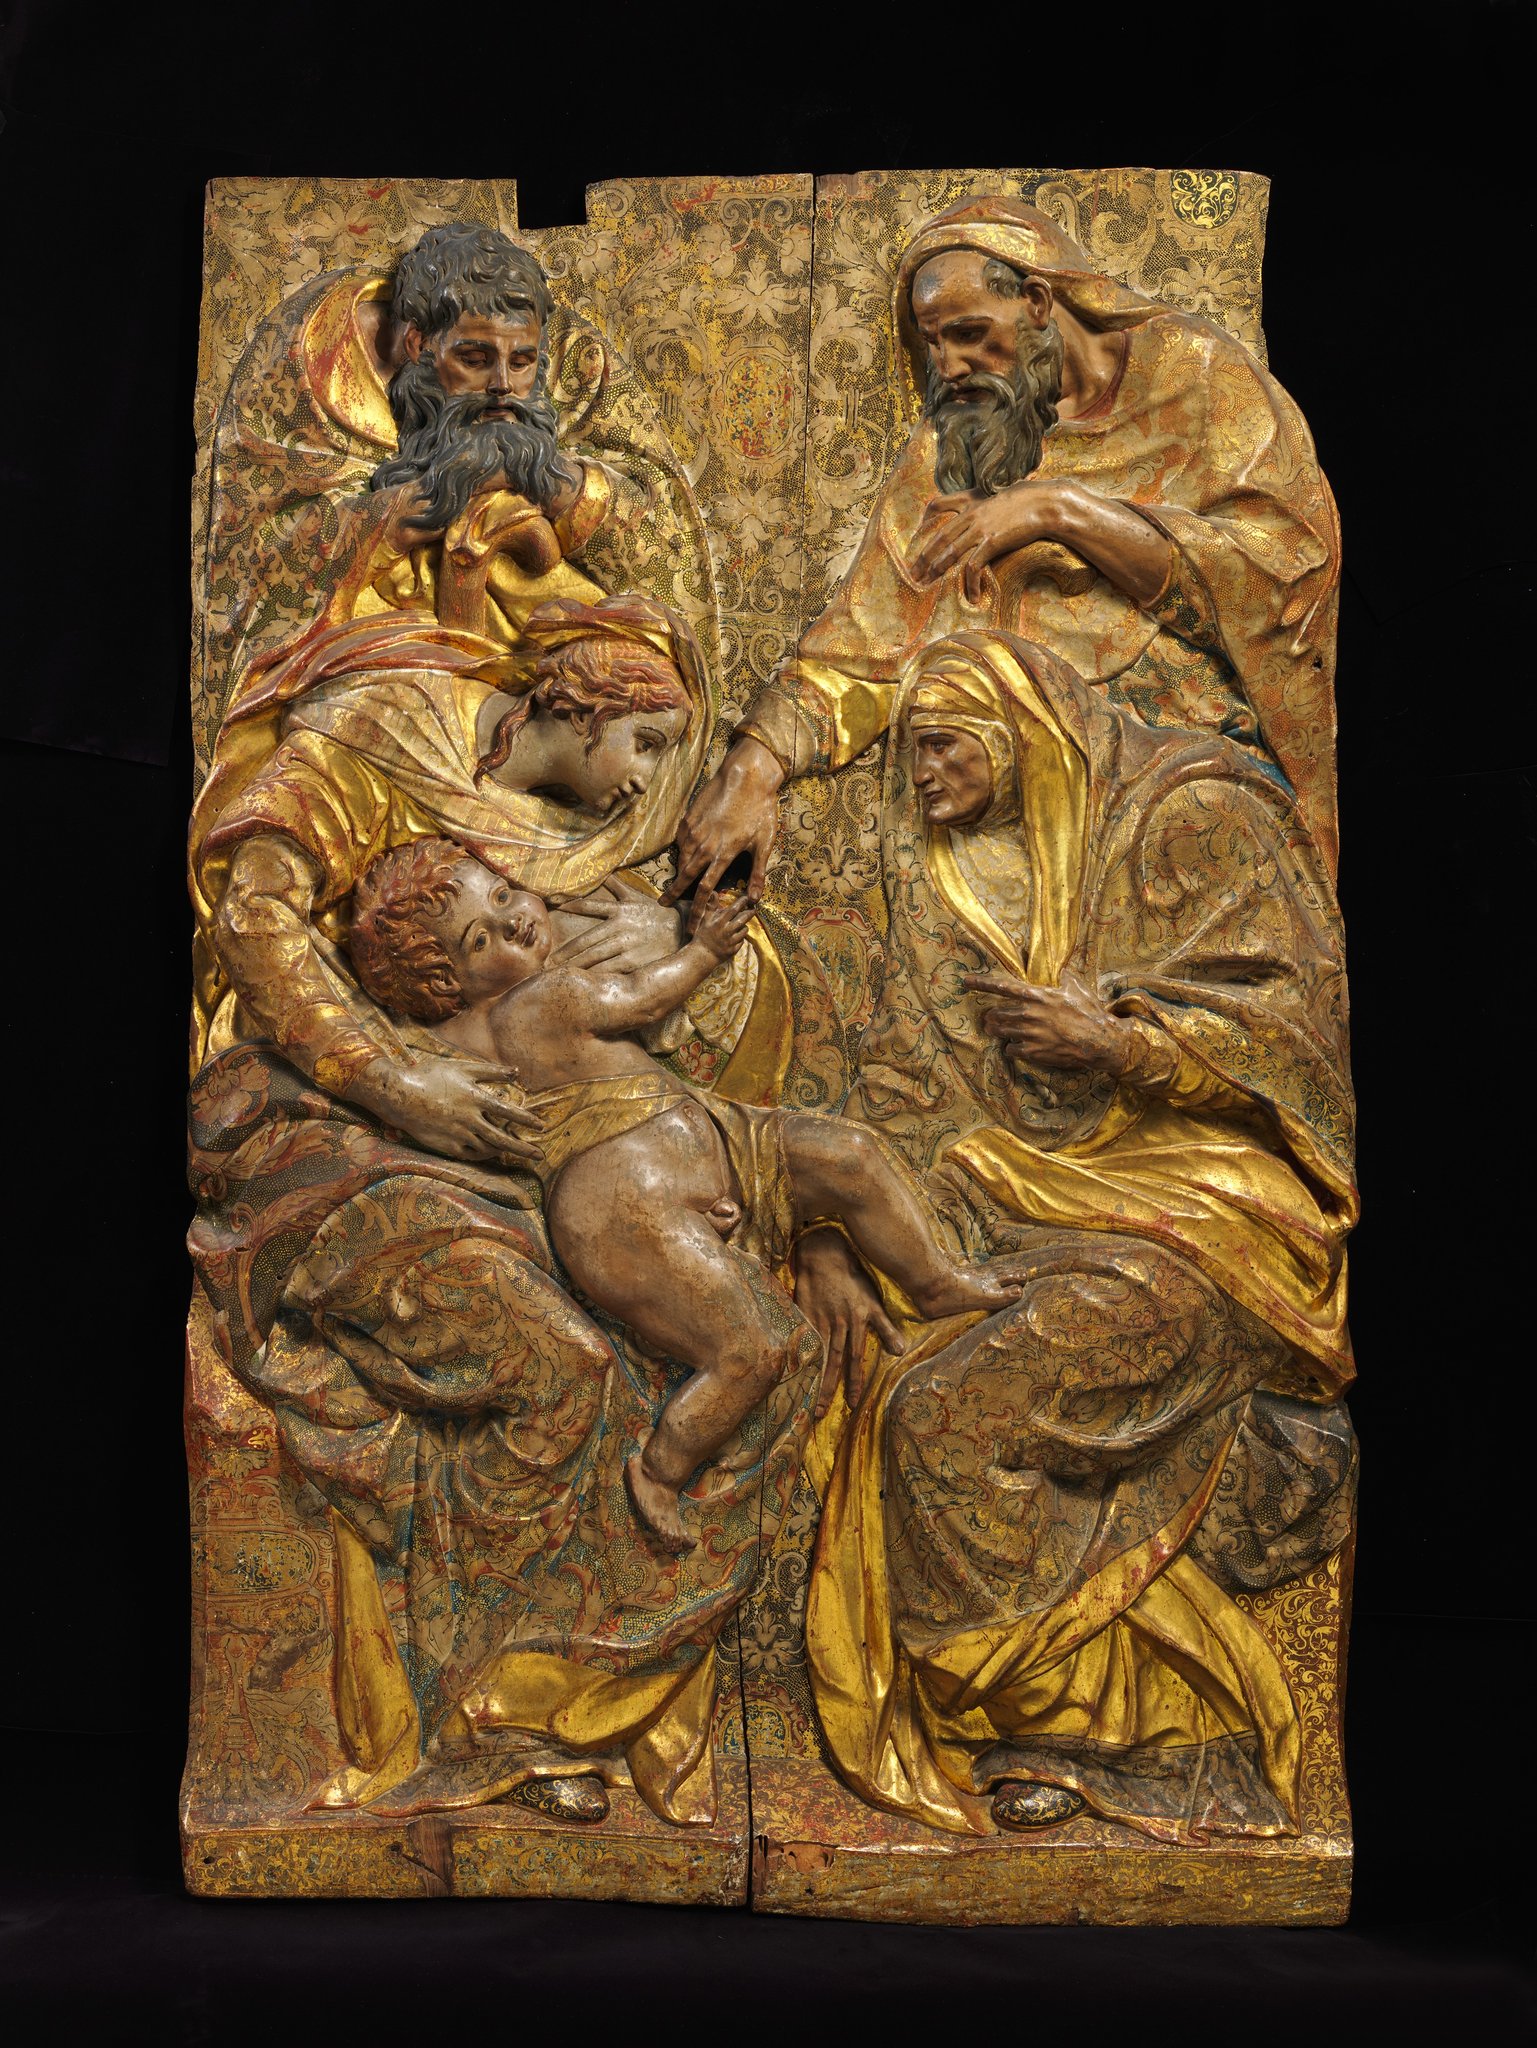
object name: relief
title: The Holy Family with Saints Anne and Joachim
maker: diego de pesquera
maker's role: artist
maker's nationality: spanish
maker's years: 1535-1582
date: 1567-1568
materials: gilt, wood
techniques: painting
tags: christ,holy family,saint anne,virgin mary